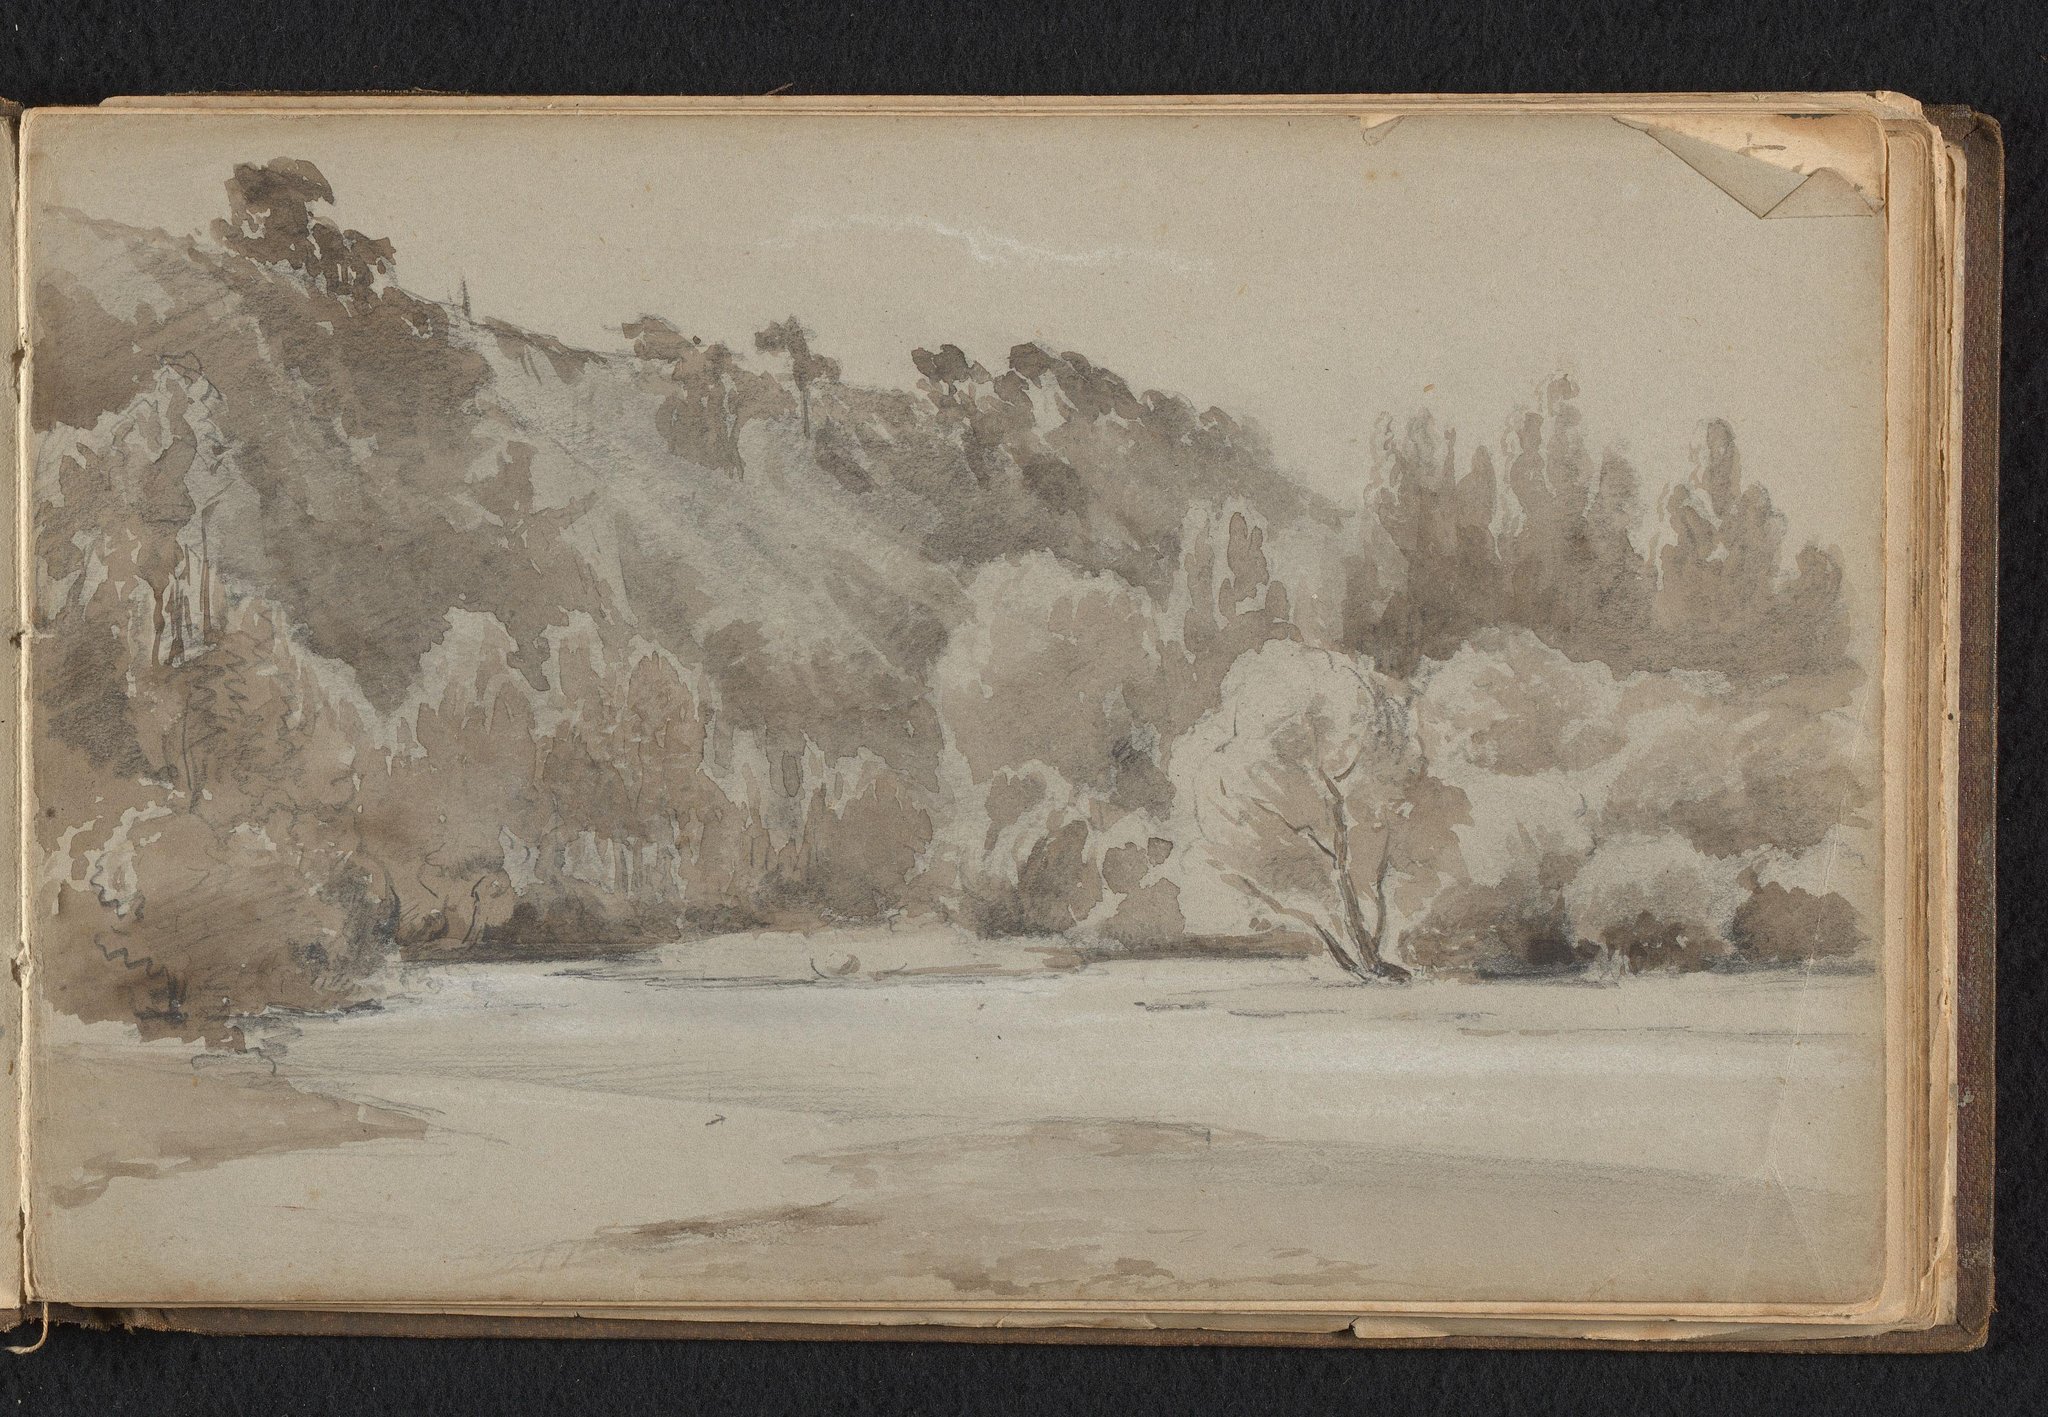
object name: sketchbook leaf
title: Heuvelig landschap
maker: jan bedijs tom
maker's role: draughtsman, painter, print maker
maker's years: 1813-1894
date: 1823-1894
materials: paper, pencil, watercolor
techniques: brush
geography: the hague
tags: low hill country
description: Pagina 32 verso uit een schetsboek met 37 bladen.